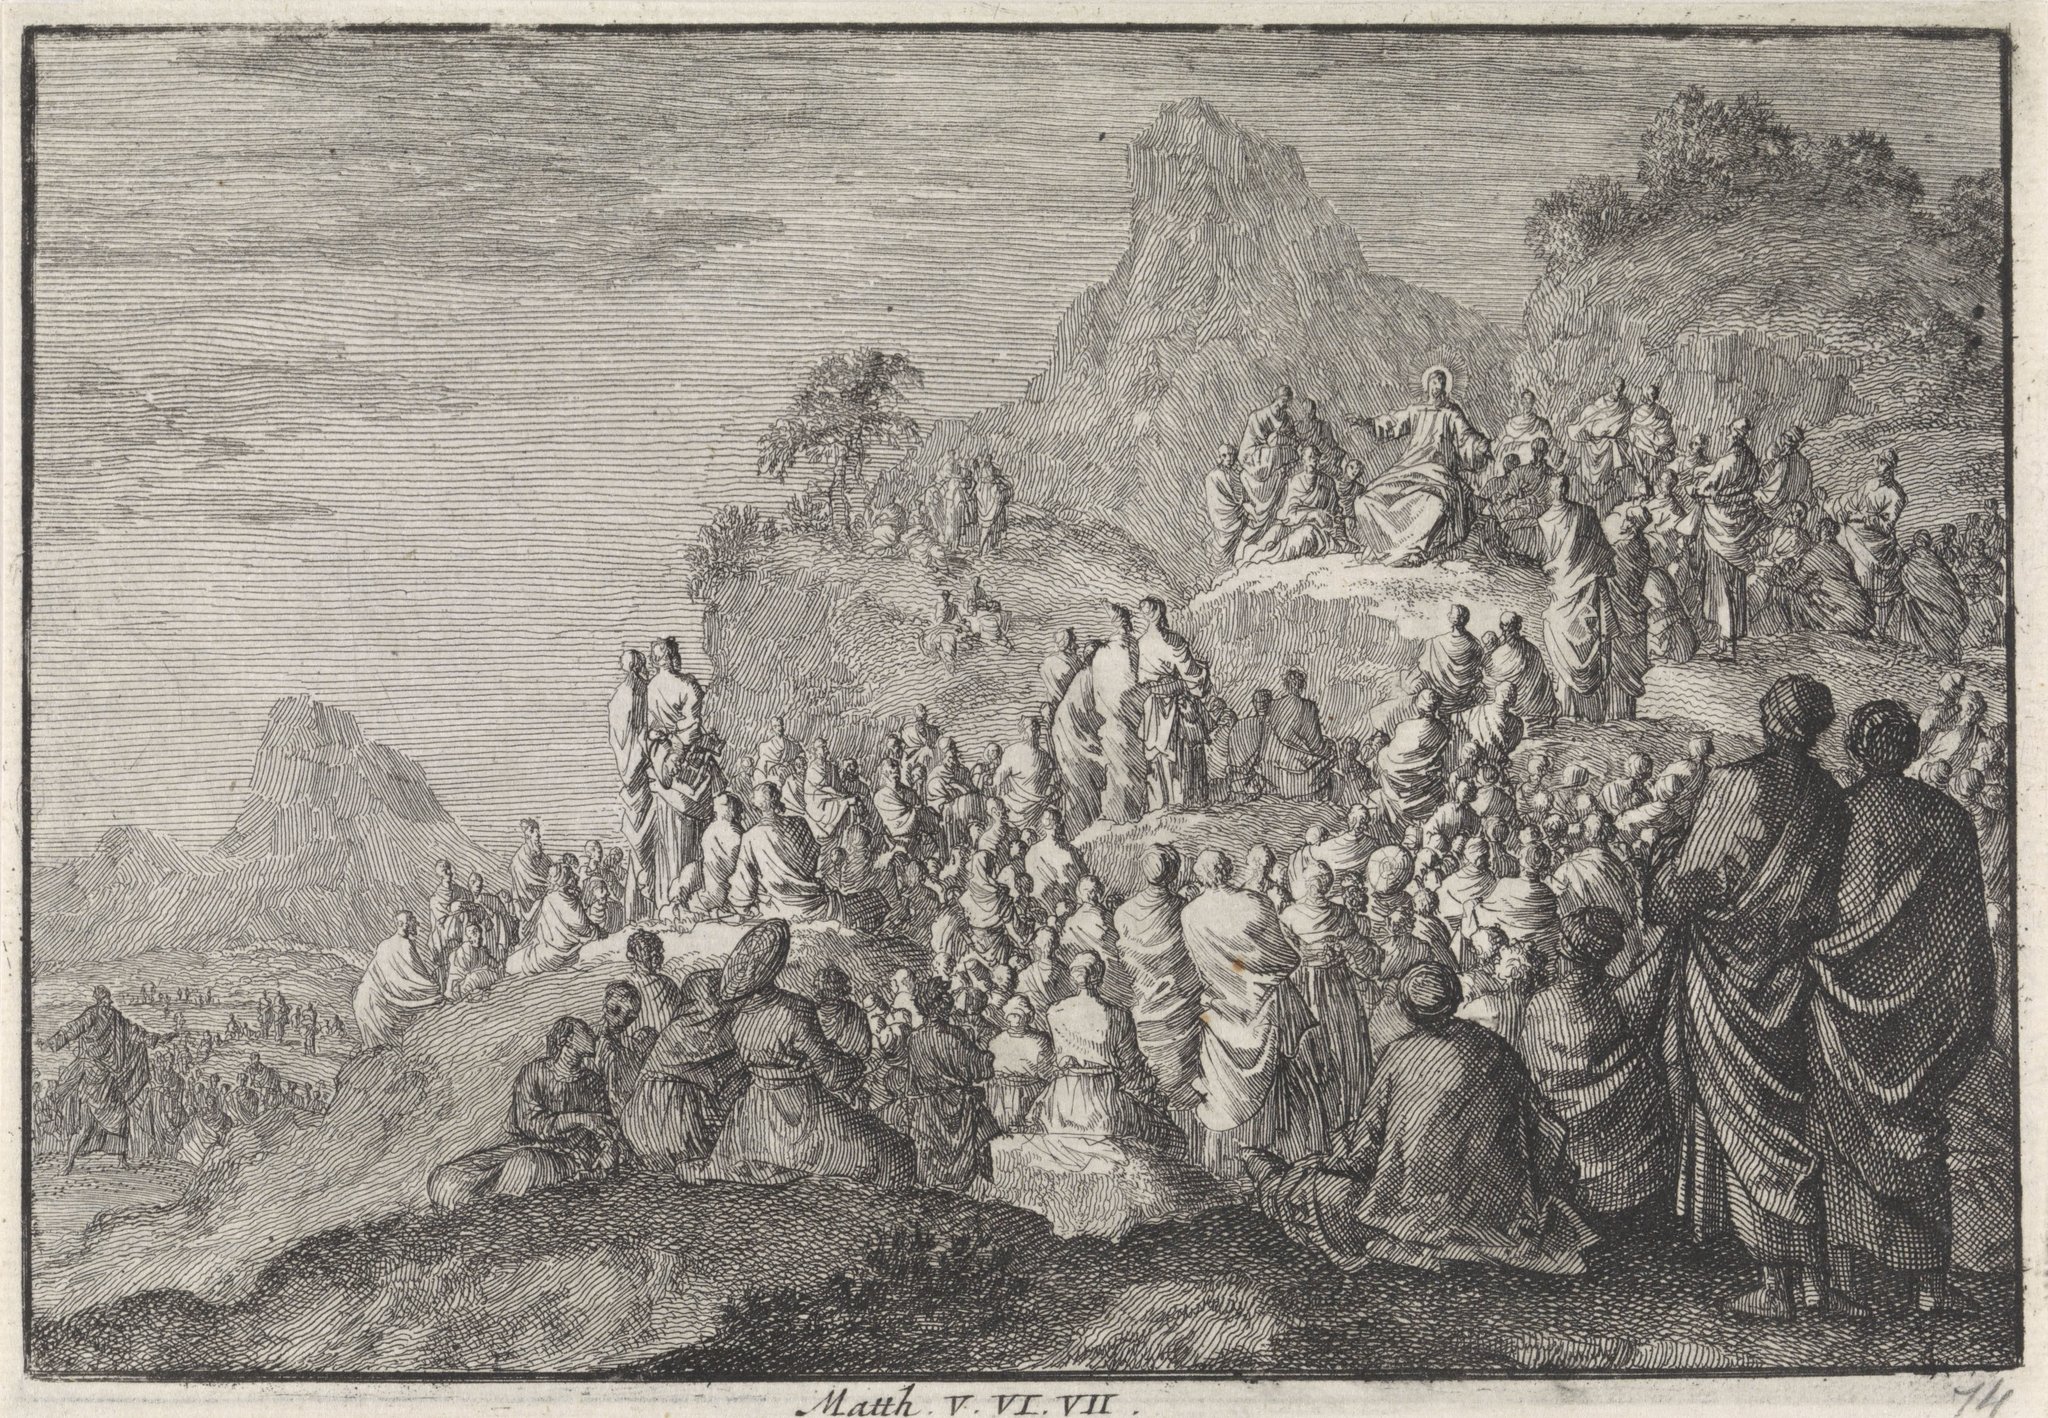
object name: print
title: Bergrede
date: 1703-1762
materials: paper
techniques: etching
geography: haarlem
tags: christ's sermon on the mount (matthew 5-7)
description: De prent komt een eerste keer voor als boekillustratie voor David Martin. Historie des Ouden en Nieuwen Testaments. Amsterdam, Pieter Mortier, 1703. Deel II. De boekillustraties voor de Mortierbijbel hebben verschillende staten en kopieën, waarbij de chronologische volgorde moeilijk te achterhalen valt. Als boekillustraties werden ze bovendien herhaaldelijk opnieuw gebruikt voor andere boekwerken.